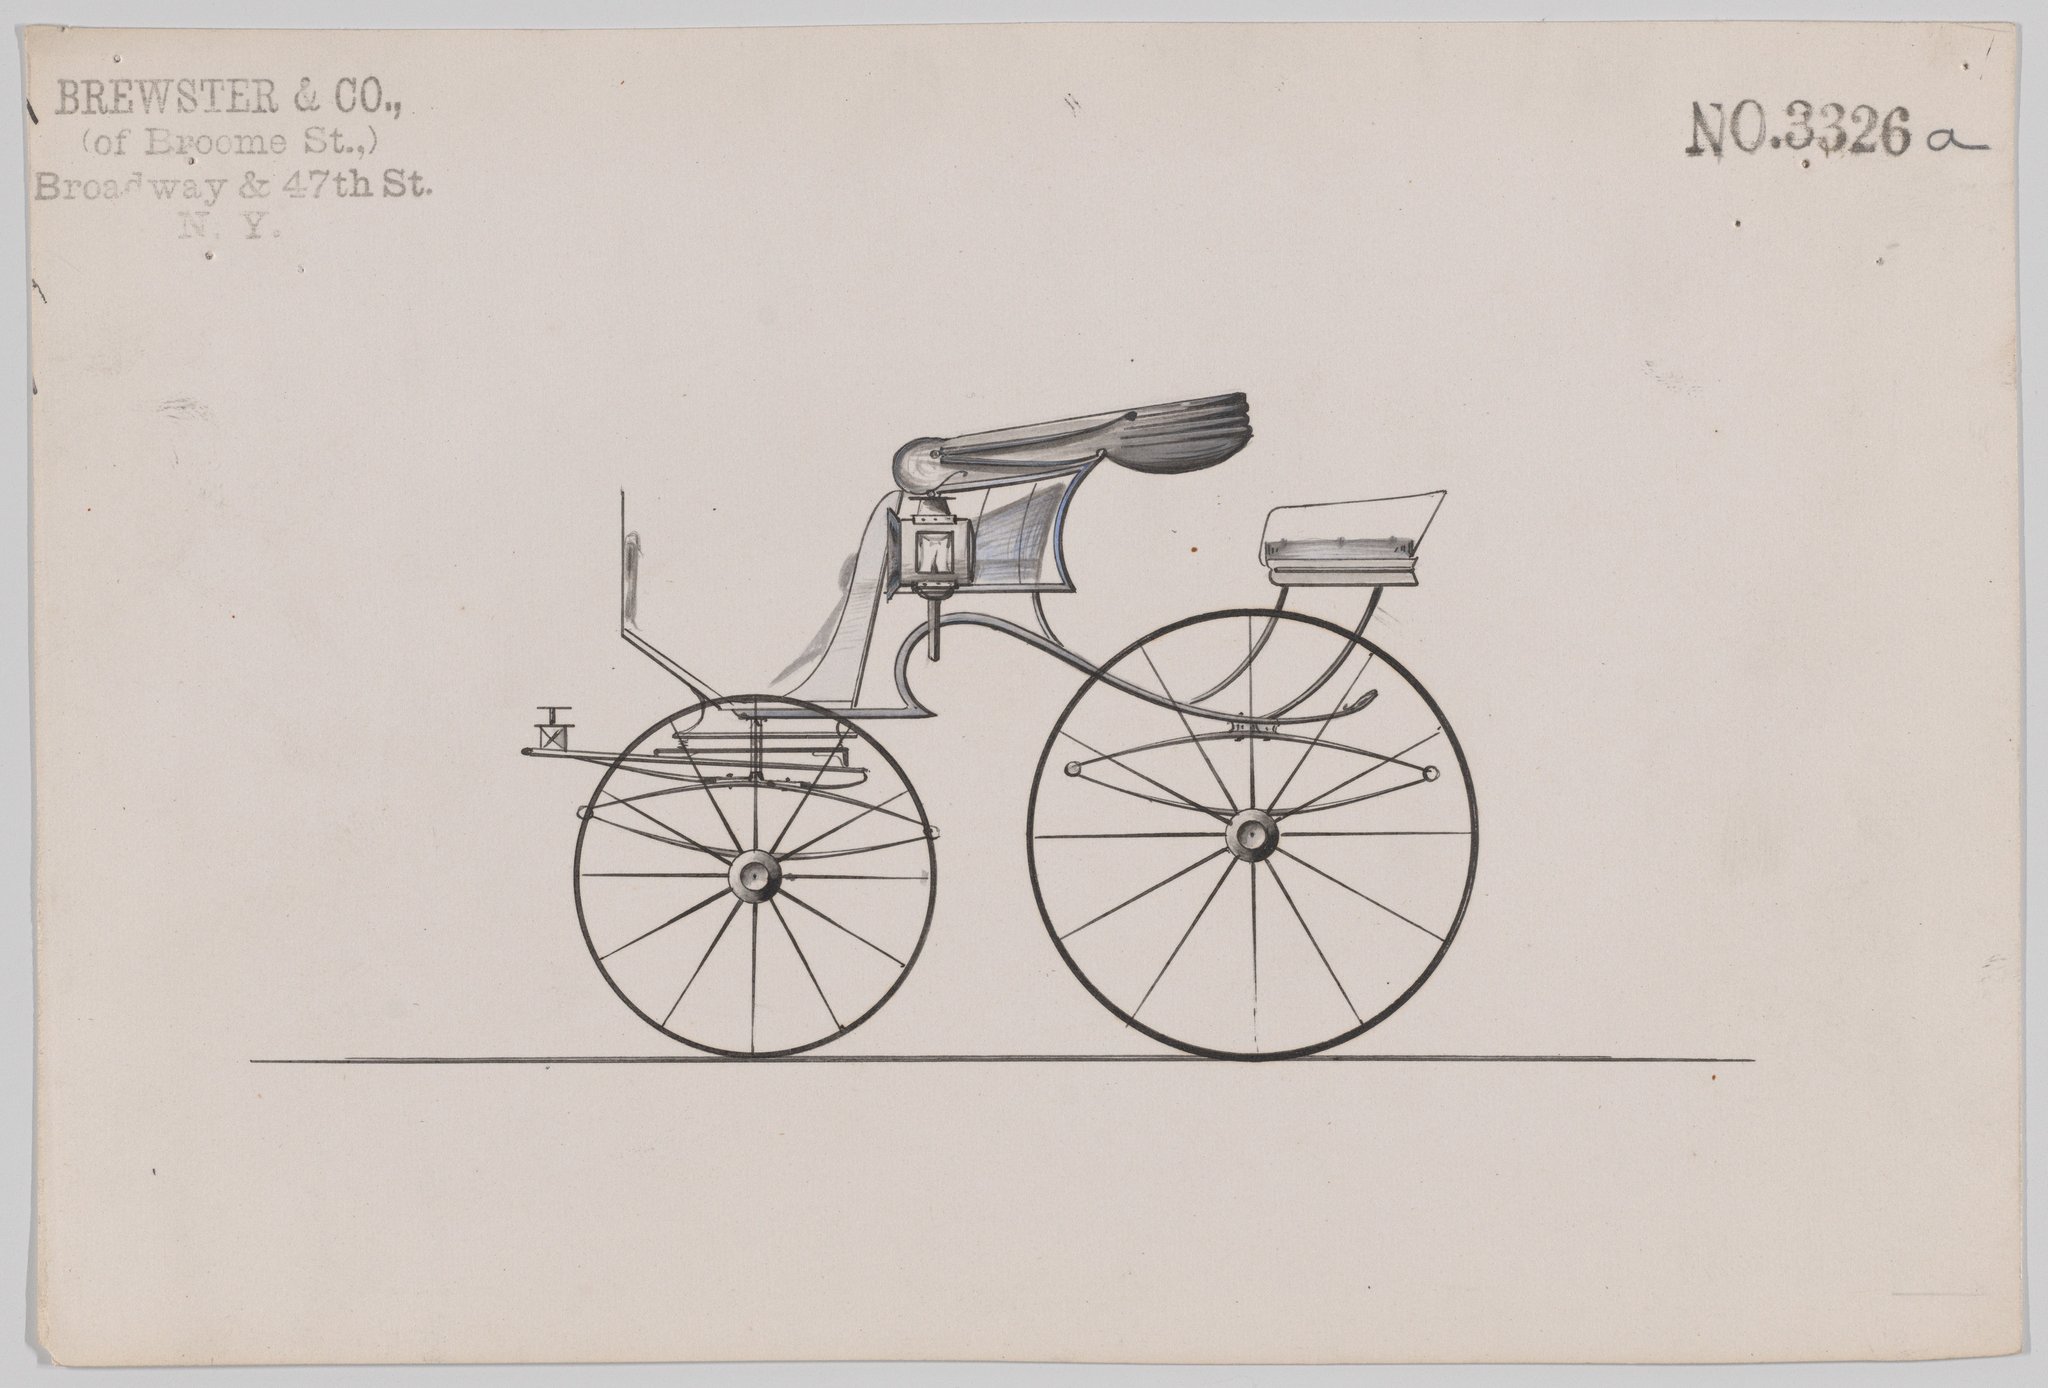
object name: drawing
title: Design for Pony Phaeton, no. 3326a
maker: brewster & co.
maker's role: manufacturer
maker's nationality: american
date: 1877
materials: graphite, ink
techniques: pen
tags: carriages